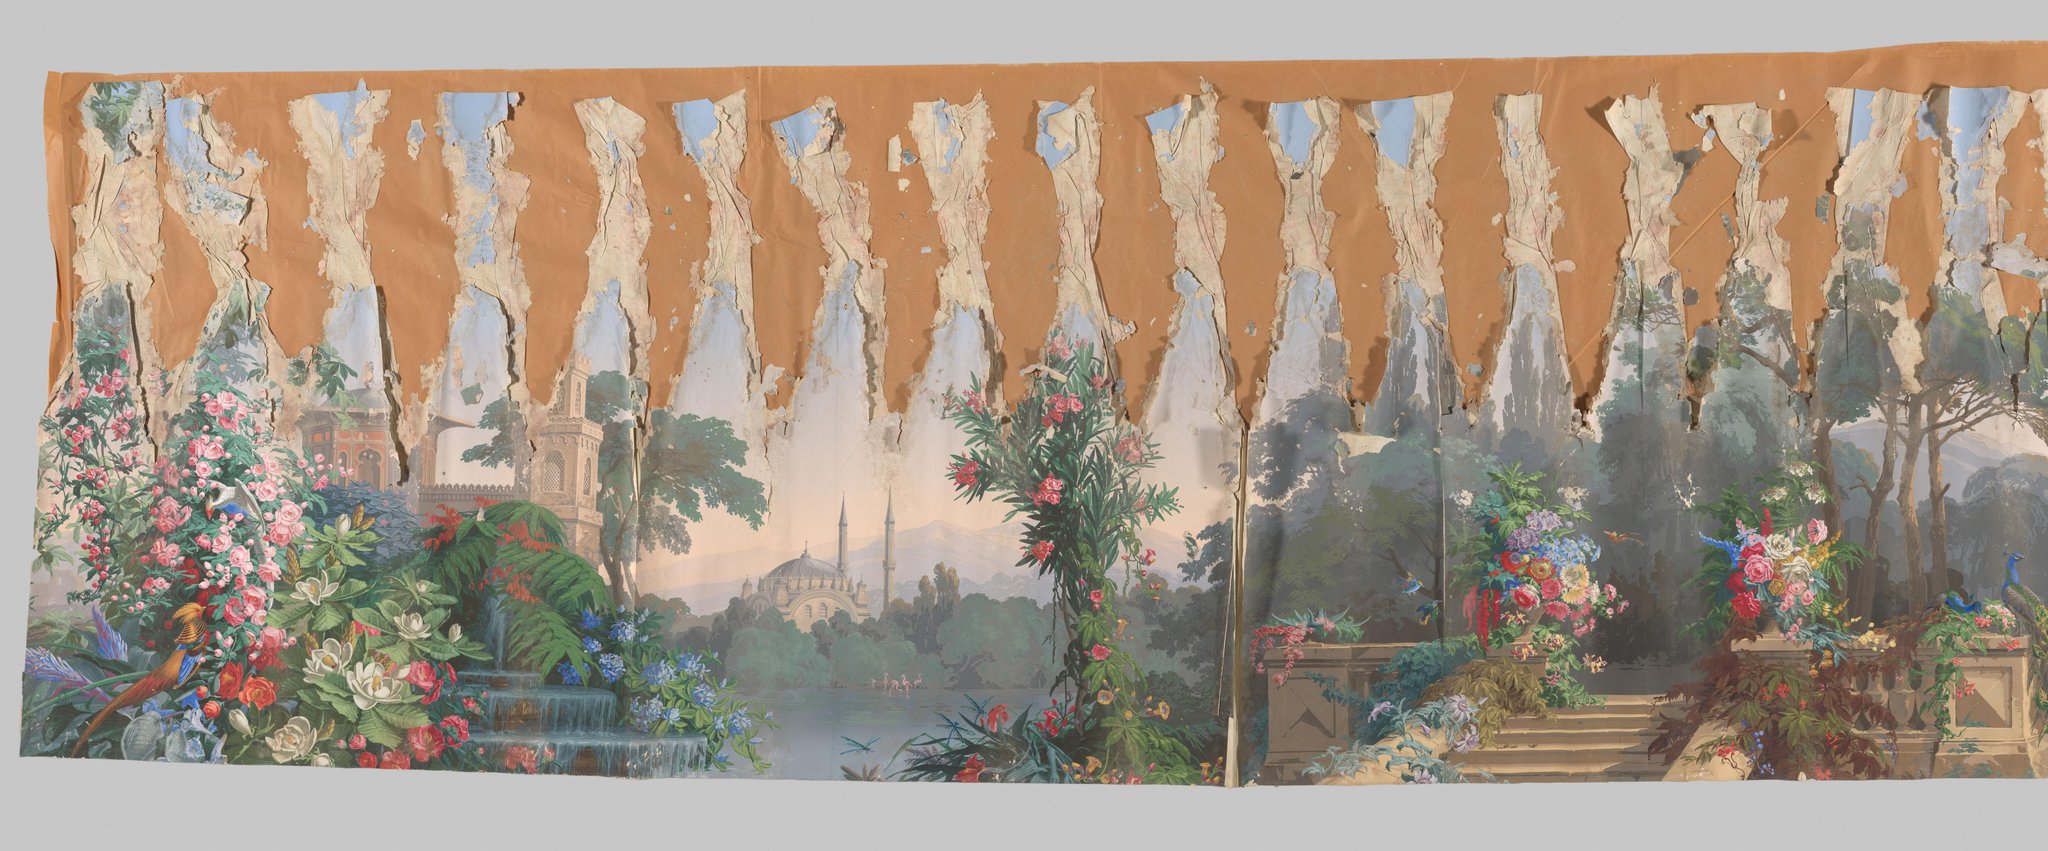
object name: interieuronderdeel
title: Rol kamerbehangsel van papier peint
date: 1800-1850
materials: paper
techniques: painted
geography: rixheim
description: Rol kamerbehangsel in papier peint met voorstellingen van idyllische landschappen, waar figuren zich op ontspannen manier in bewegen. Deze rol maakt deel uit van een verzameling van zes rollen; enkele rollen hebben repeterende langwerpige verticale vochtvlekken of zelfs gaten.